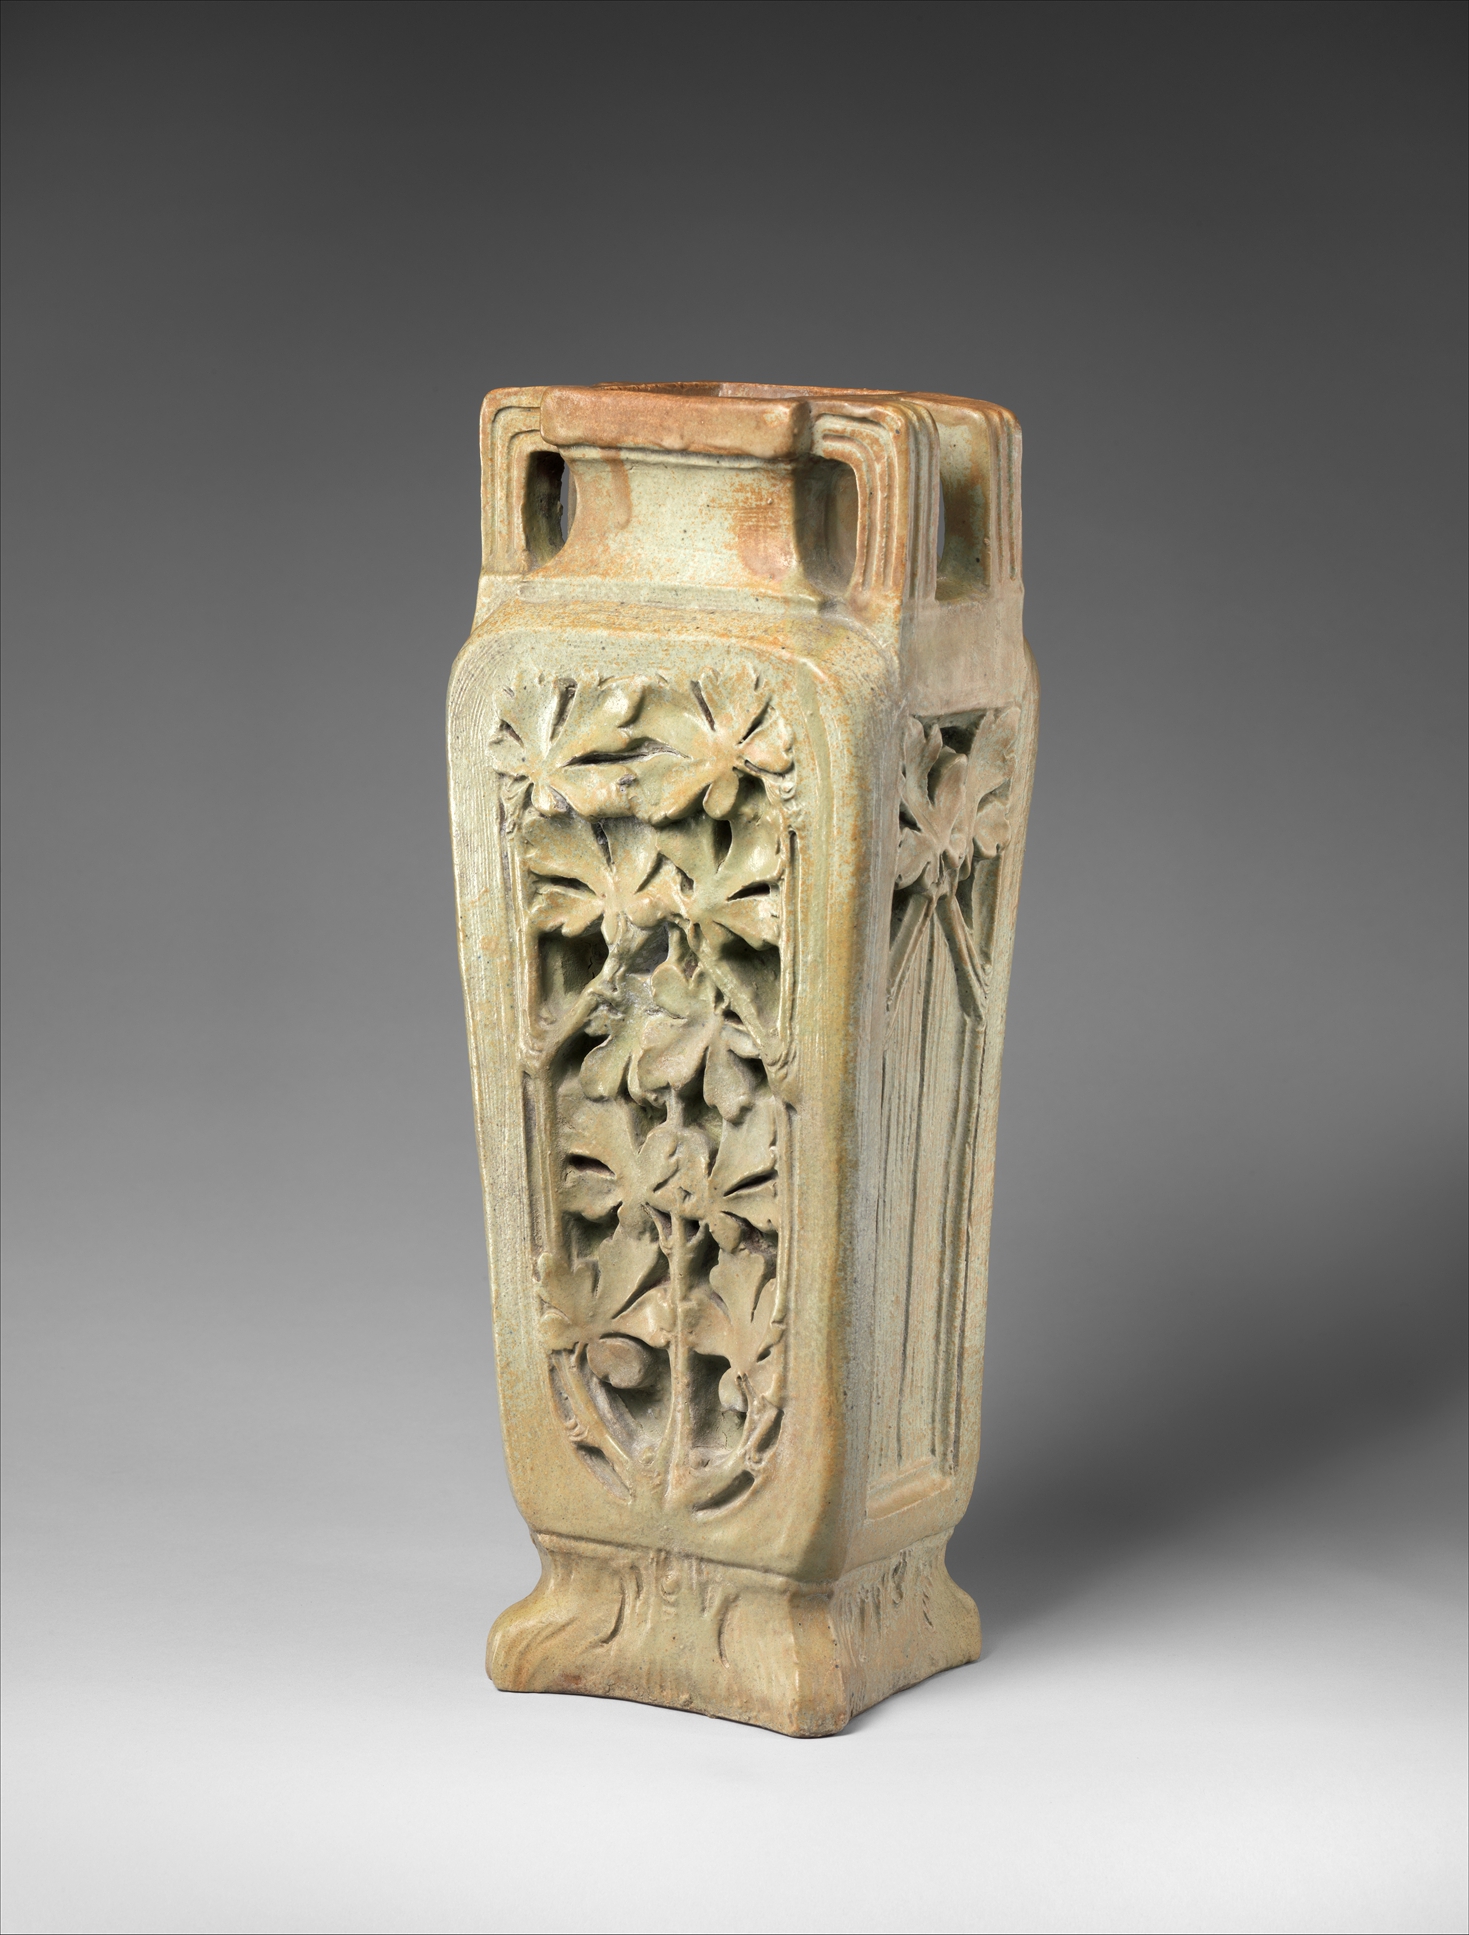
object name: vase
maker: georges hoentschel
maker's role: maker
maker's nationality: french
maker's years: 1855-1915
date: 1890-1900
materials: stoneware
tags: flowers